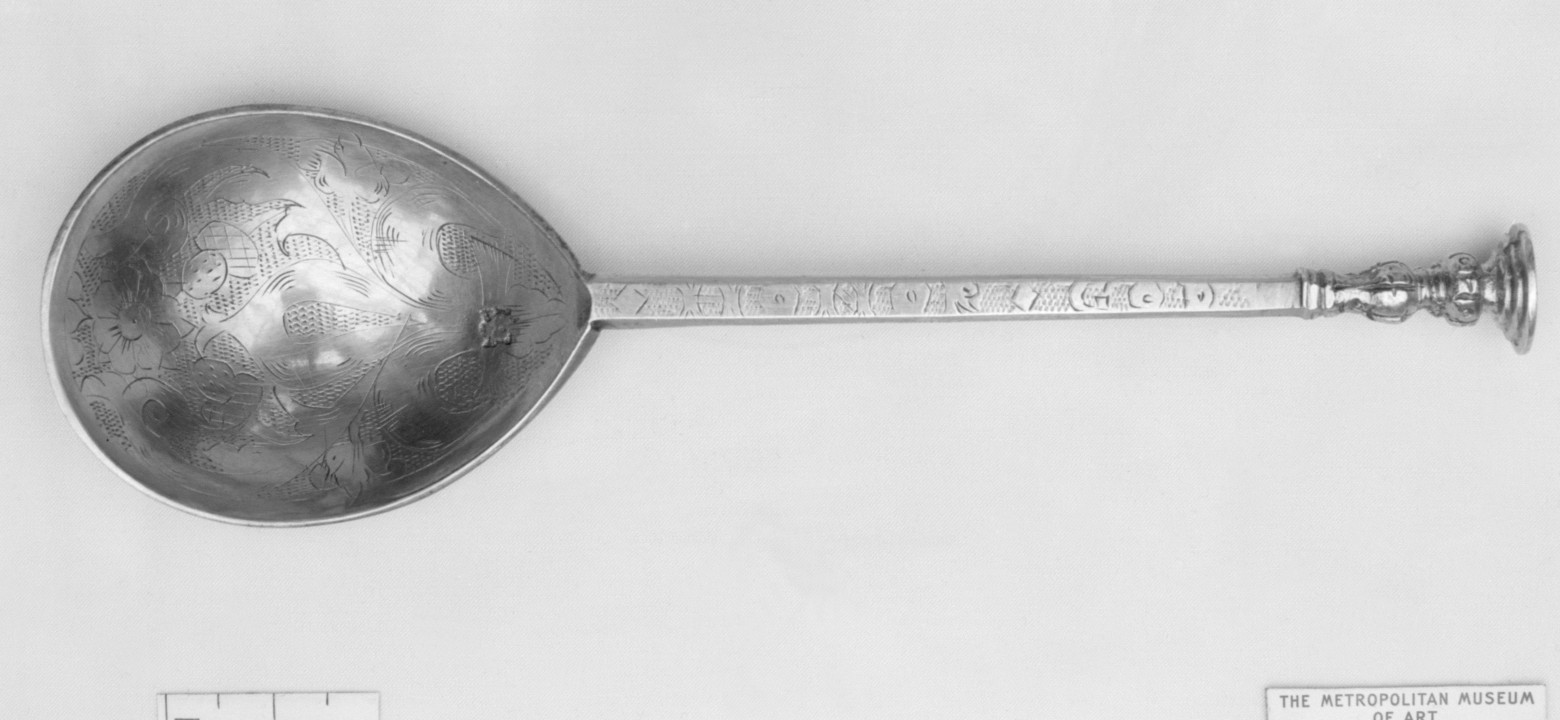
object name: spoon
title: Seal-top spoon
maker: robert matthew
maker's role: silversmith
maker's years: 1622-1640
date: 1630-1640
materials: silver gilt